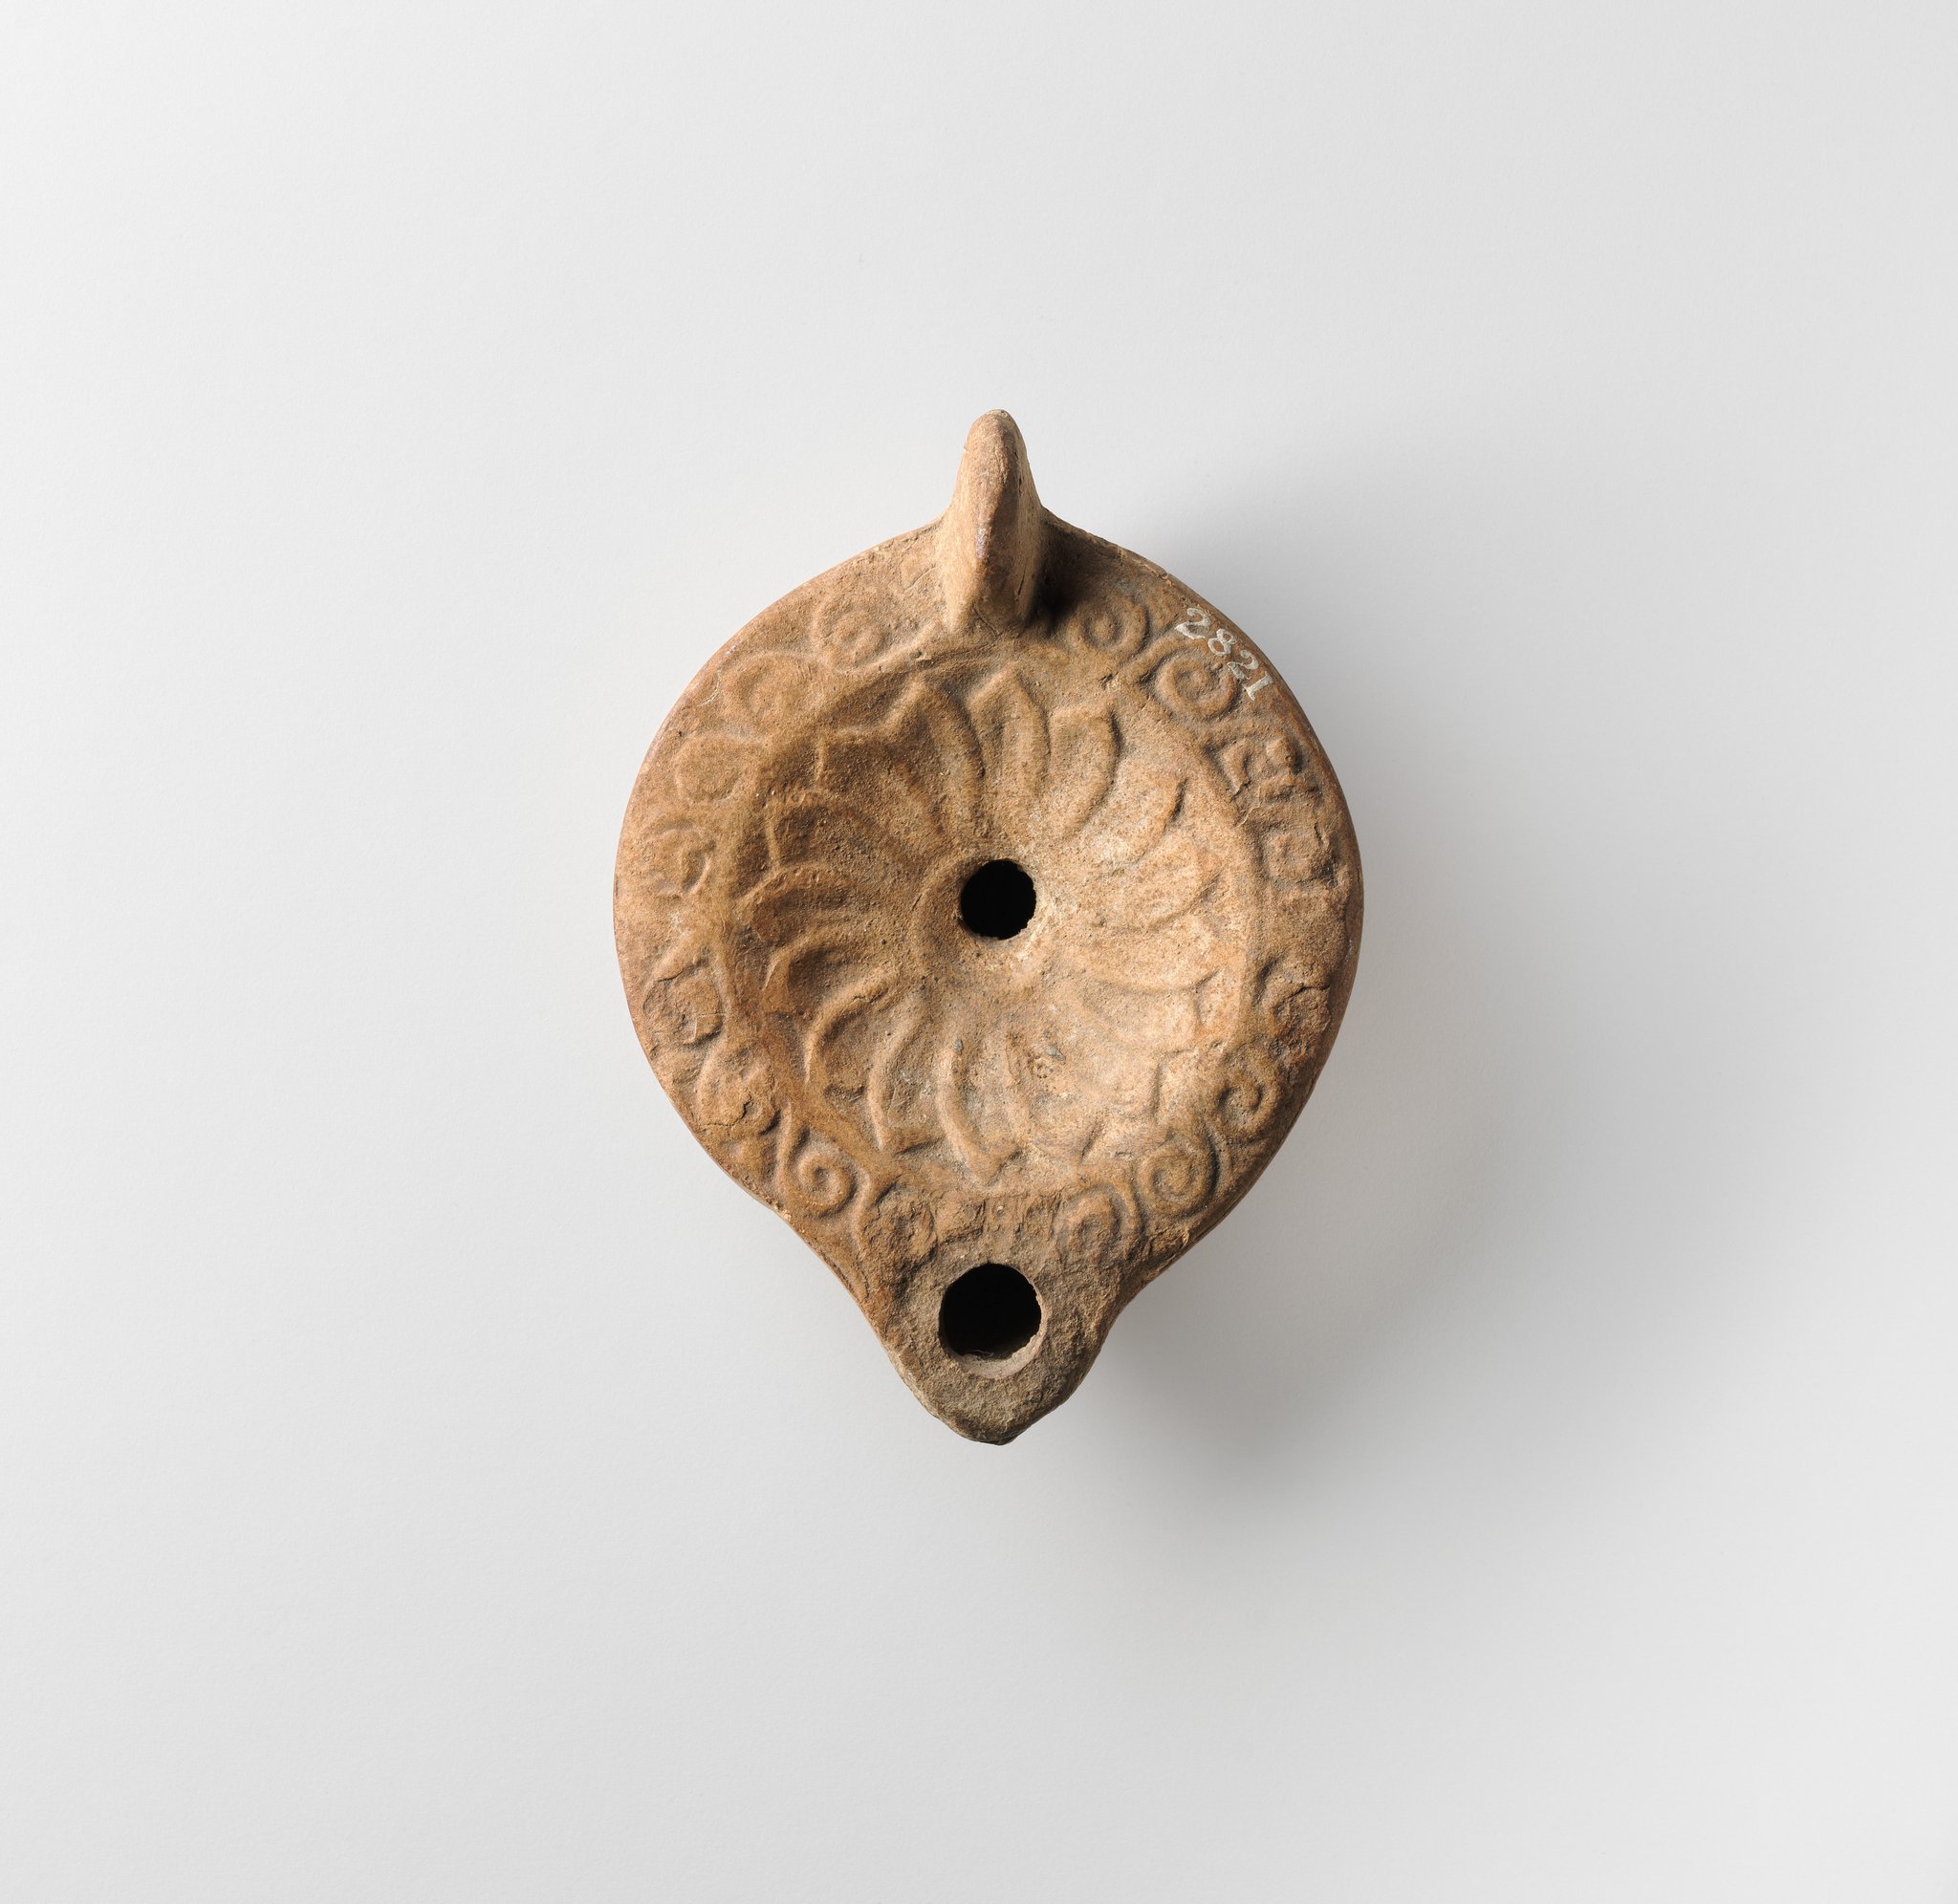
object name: lamp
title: Terracotta oil lamp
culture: roman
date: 201-300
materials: terracotta